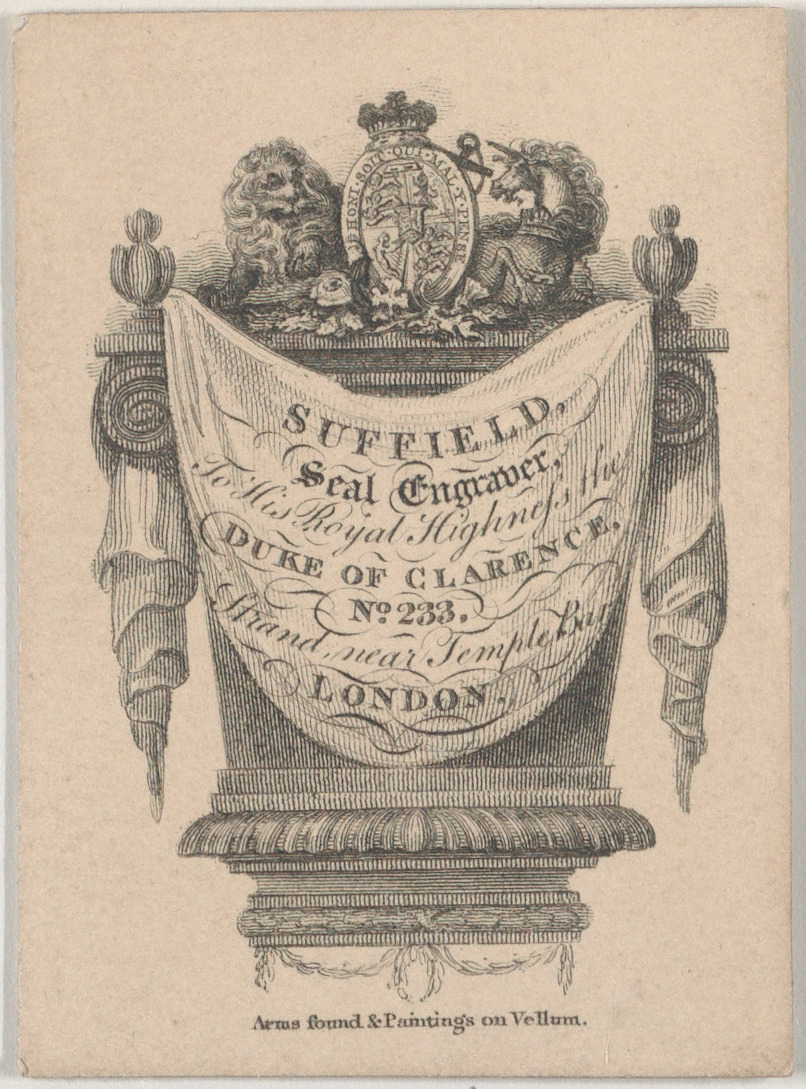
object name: print, trade card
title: Trade Card for Suffield, seal engraver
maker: anonymous, british, late 18th–early 19th century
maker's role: artist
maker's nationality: british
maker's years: 1771-1835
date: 1767-1833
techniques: engraving